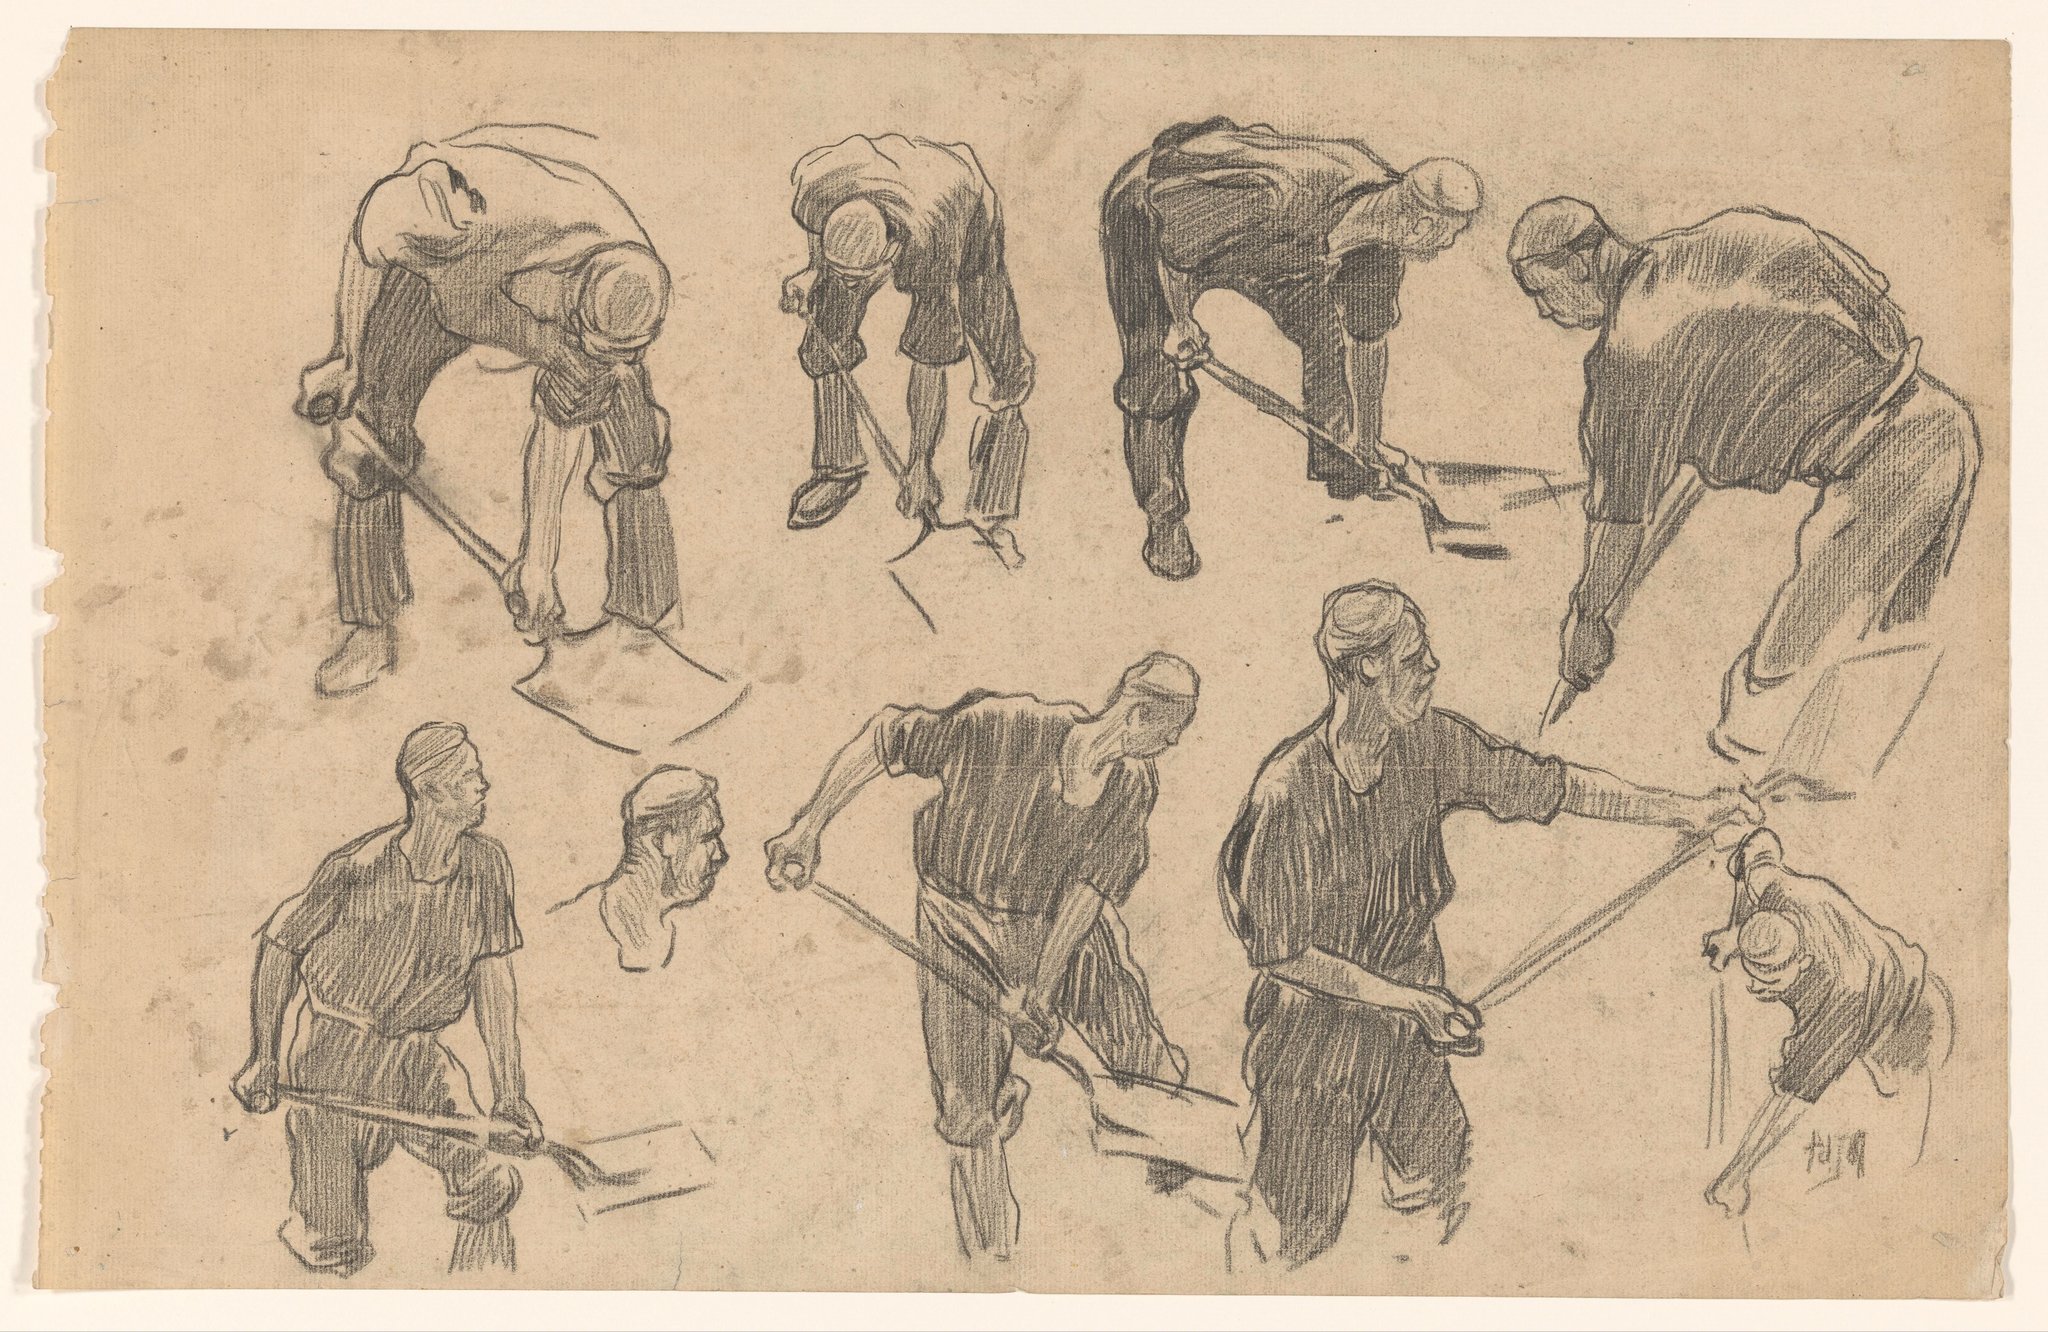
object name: drawing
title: Studieblad met schetsen van een spittende arbeider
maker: pieter de josselin de jong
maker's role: draughtsman, painter, print maker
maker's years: 1861-1906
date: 1871-1906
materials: chalk, paper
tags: digging (industrial process)